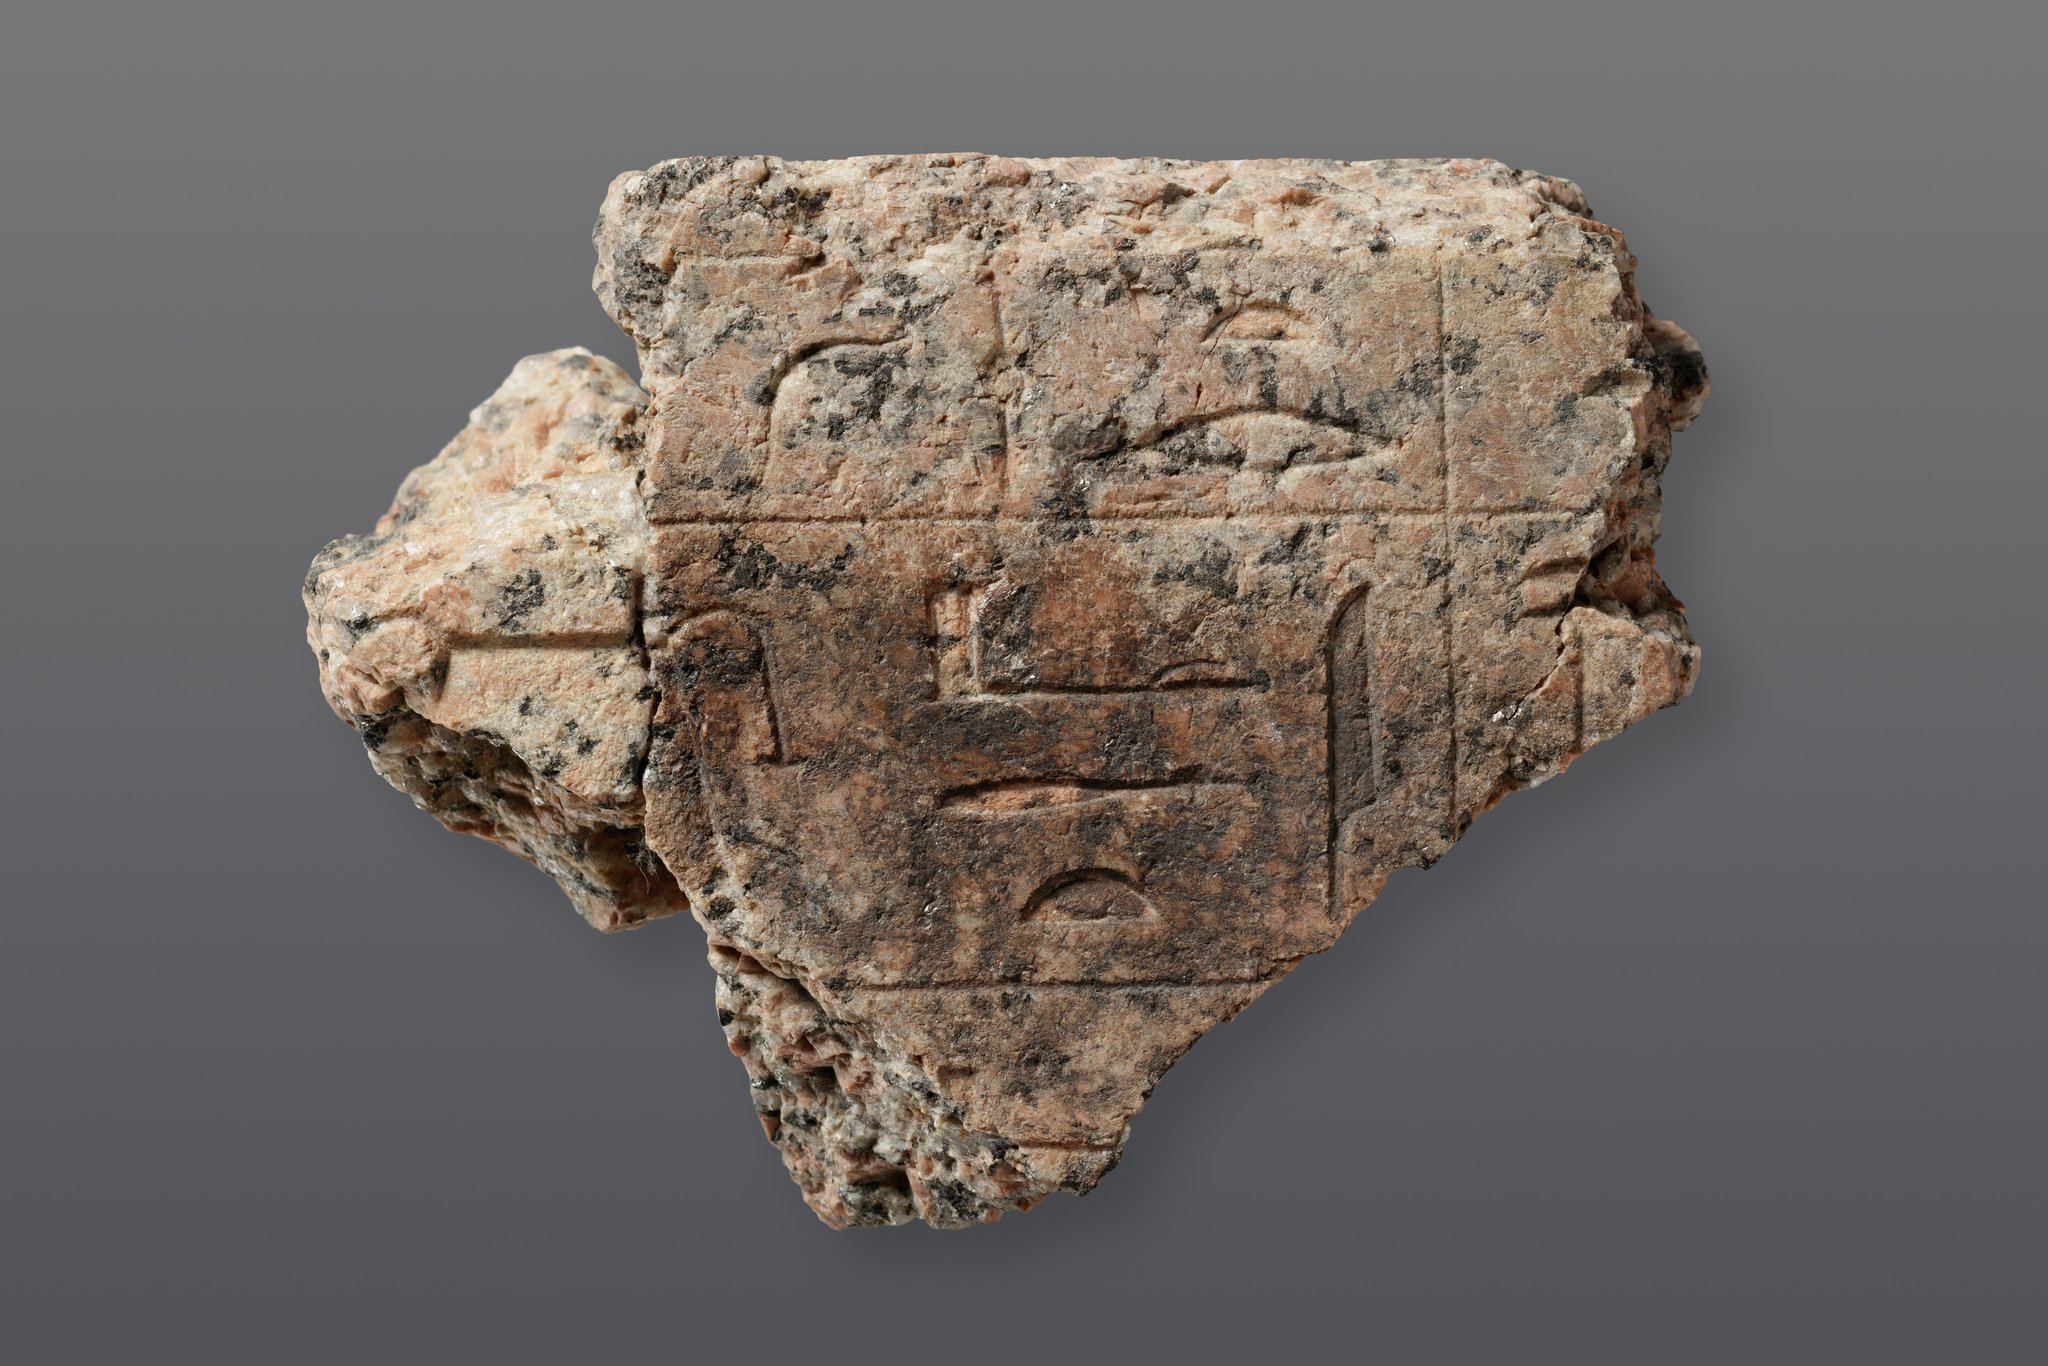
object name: relief fragment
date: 1981-1640 BCE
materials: granite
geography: egypt